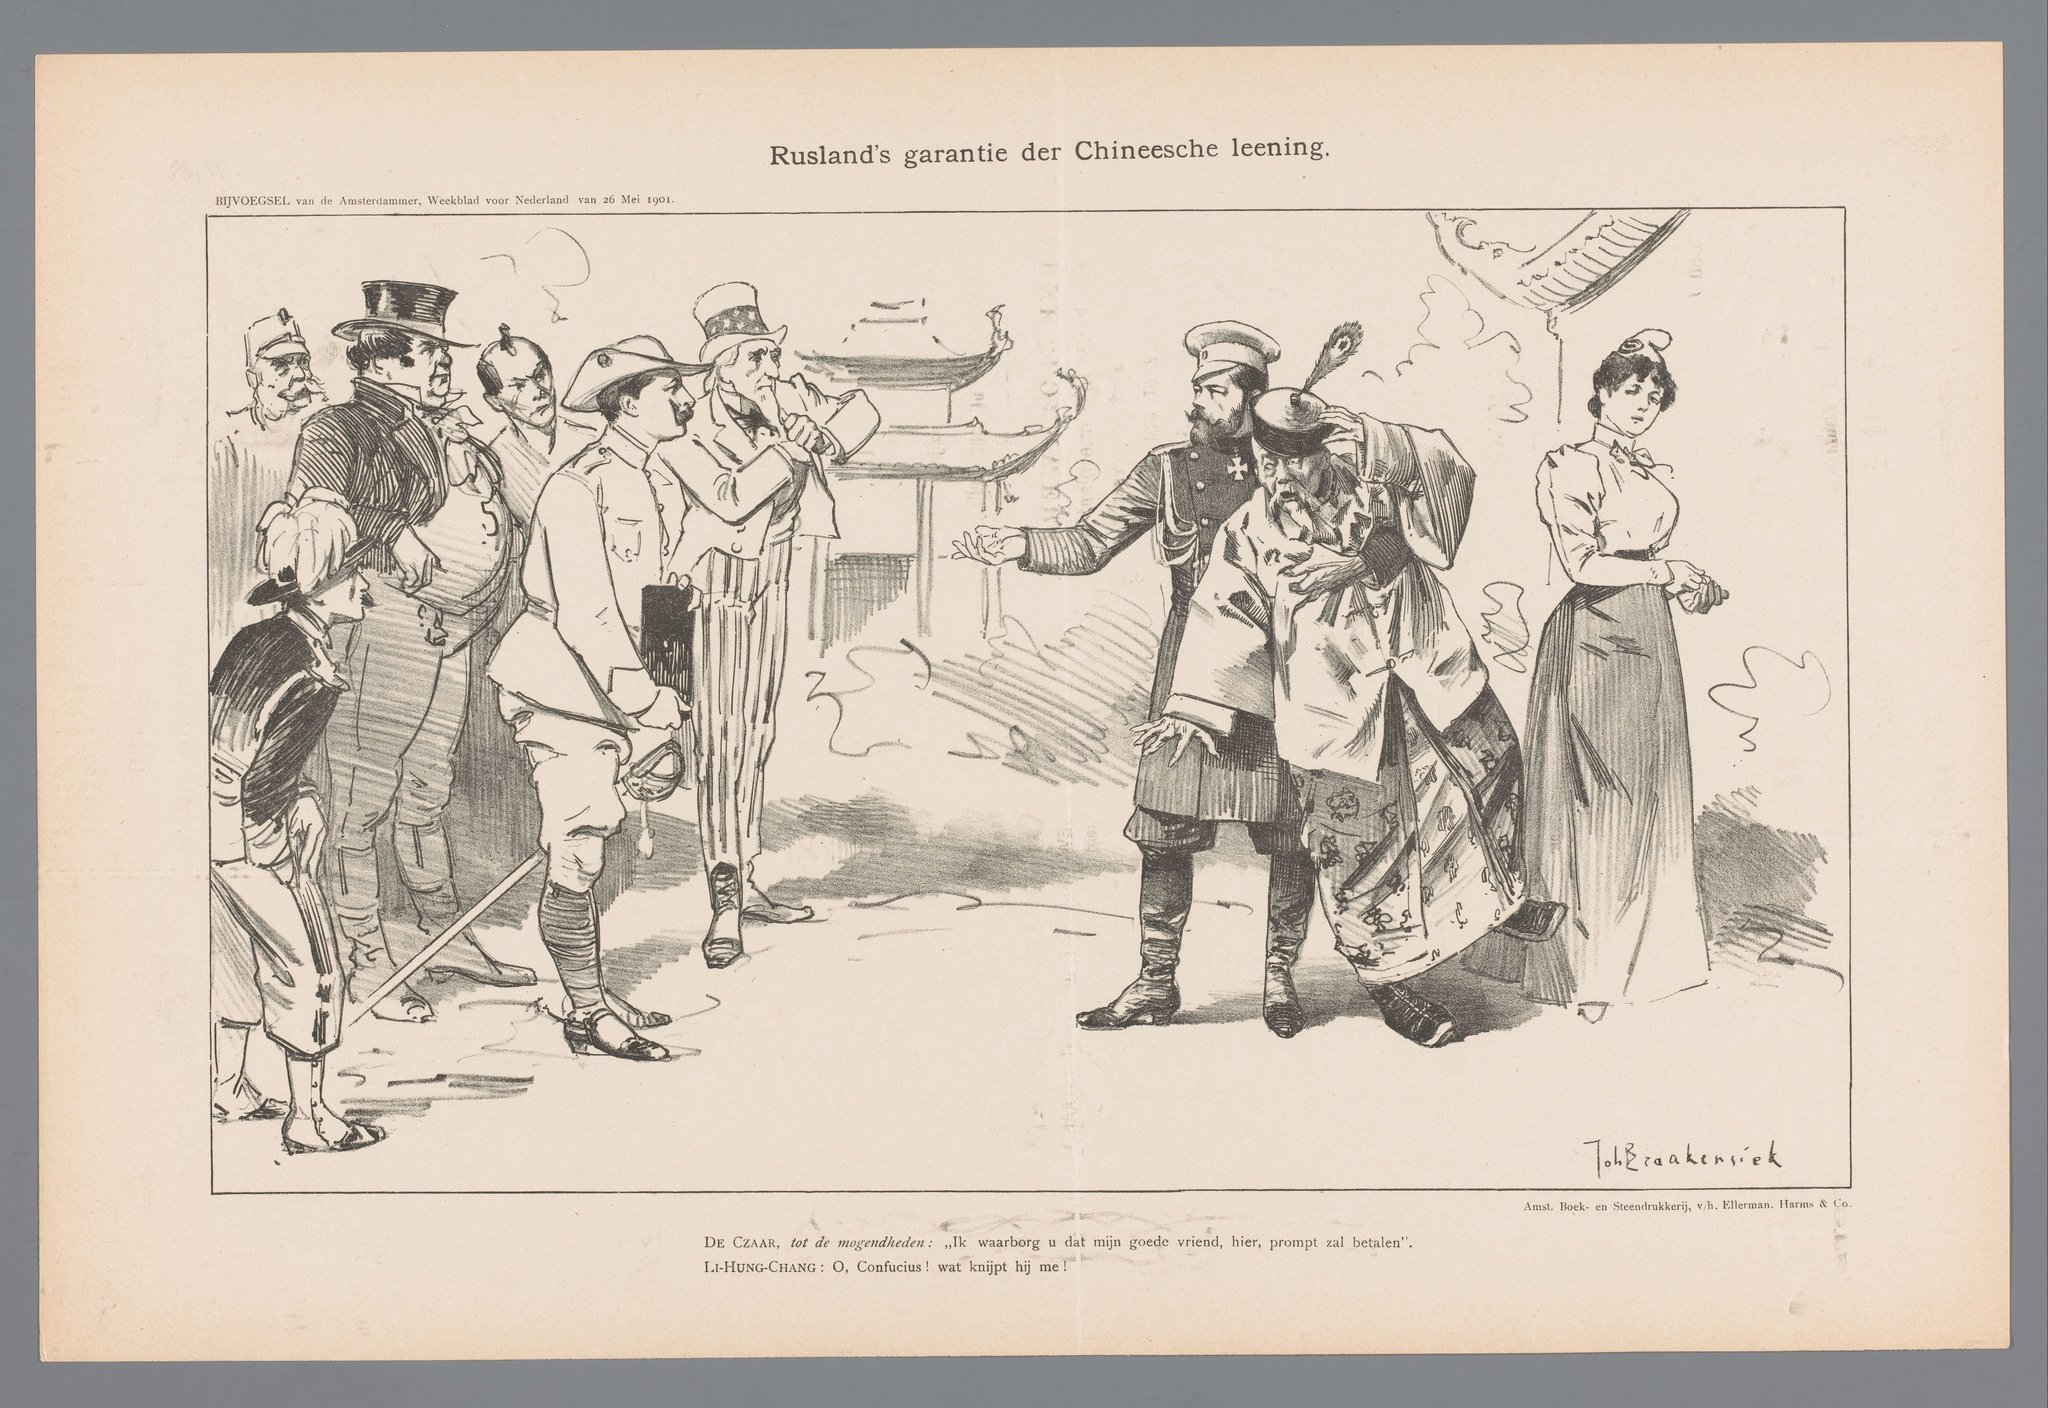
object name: cartoon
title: Rusland's garantie der Chineesche leening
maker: johan braakensiek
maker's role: draughtsman, print maker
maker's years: 1858-1940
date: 1901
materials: paper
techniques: lithograph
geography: amsterdam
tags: china, politician, historical persons, ruler, sovereign, personifications of countries, nations, states, districts, etc. (+ nation; national), political caricatures and satires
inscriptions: date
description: Prent uit het bijvoegsel van: De Amsterdammer. Weekblad voor Nederland, 26 mei 1901.